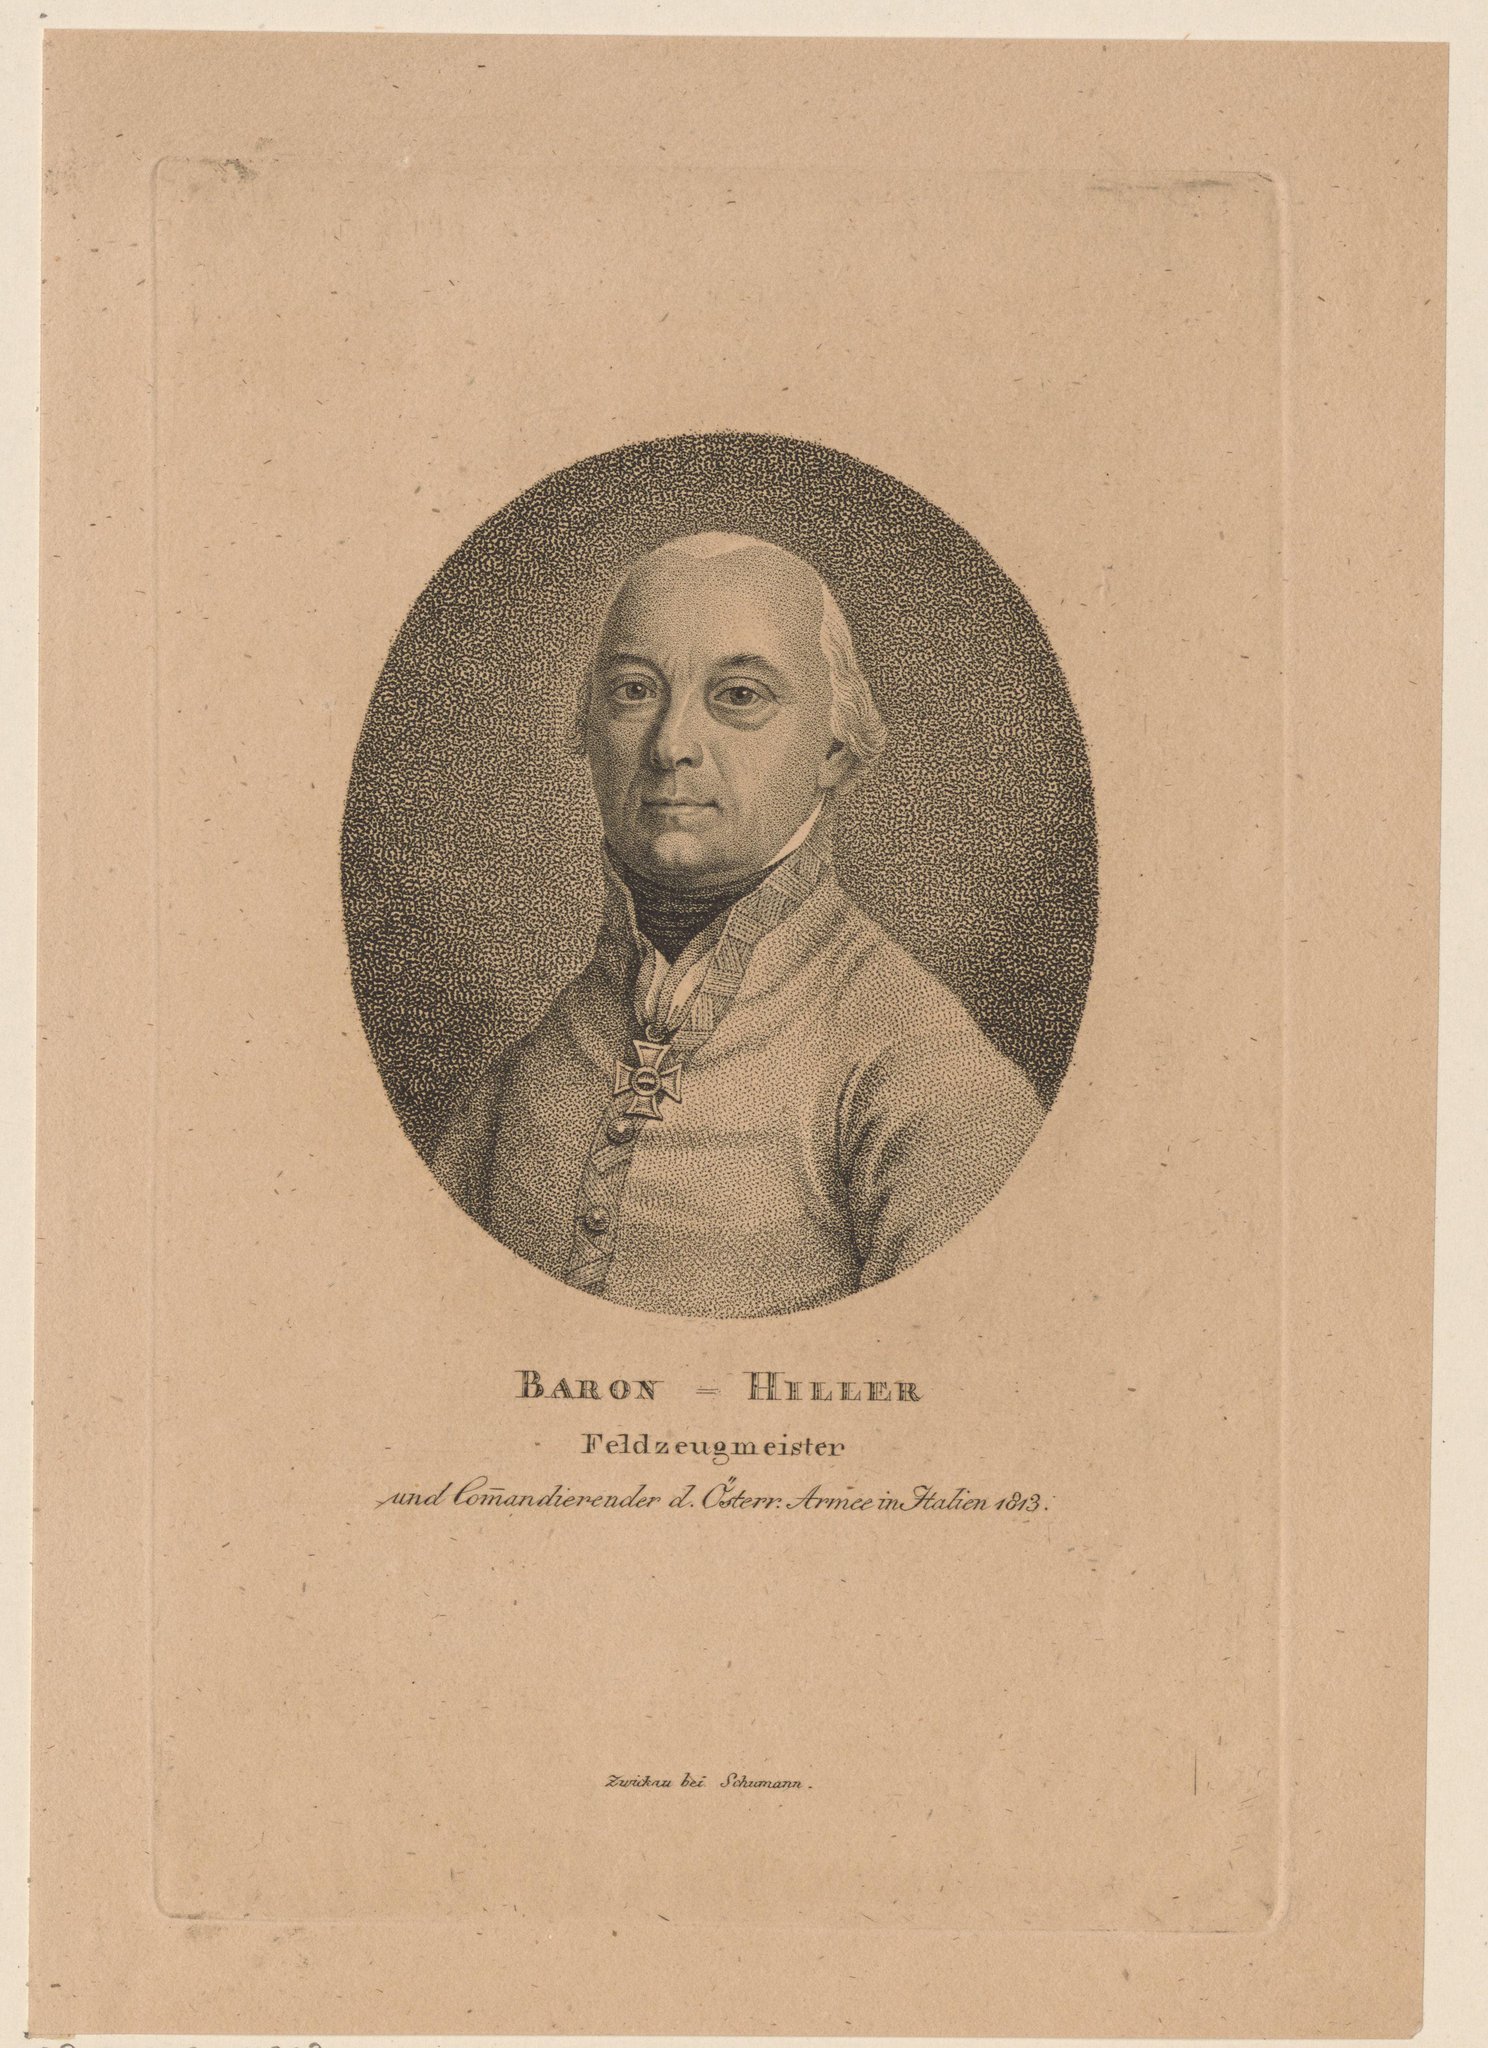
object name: print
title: Portret van Johann von Hiller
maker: Anonymous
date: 1813-1843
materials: paper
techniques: etching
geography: zwickau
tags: commander-in-chief, general, marshal, historical persons